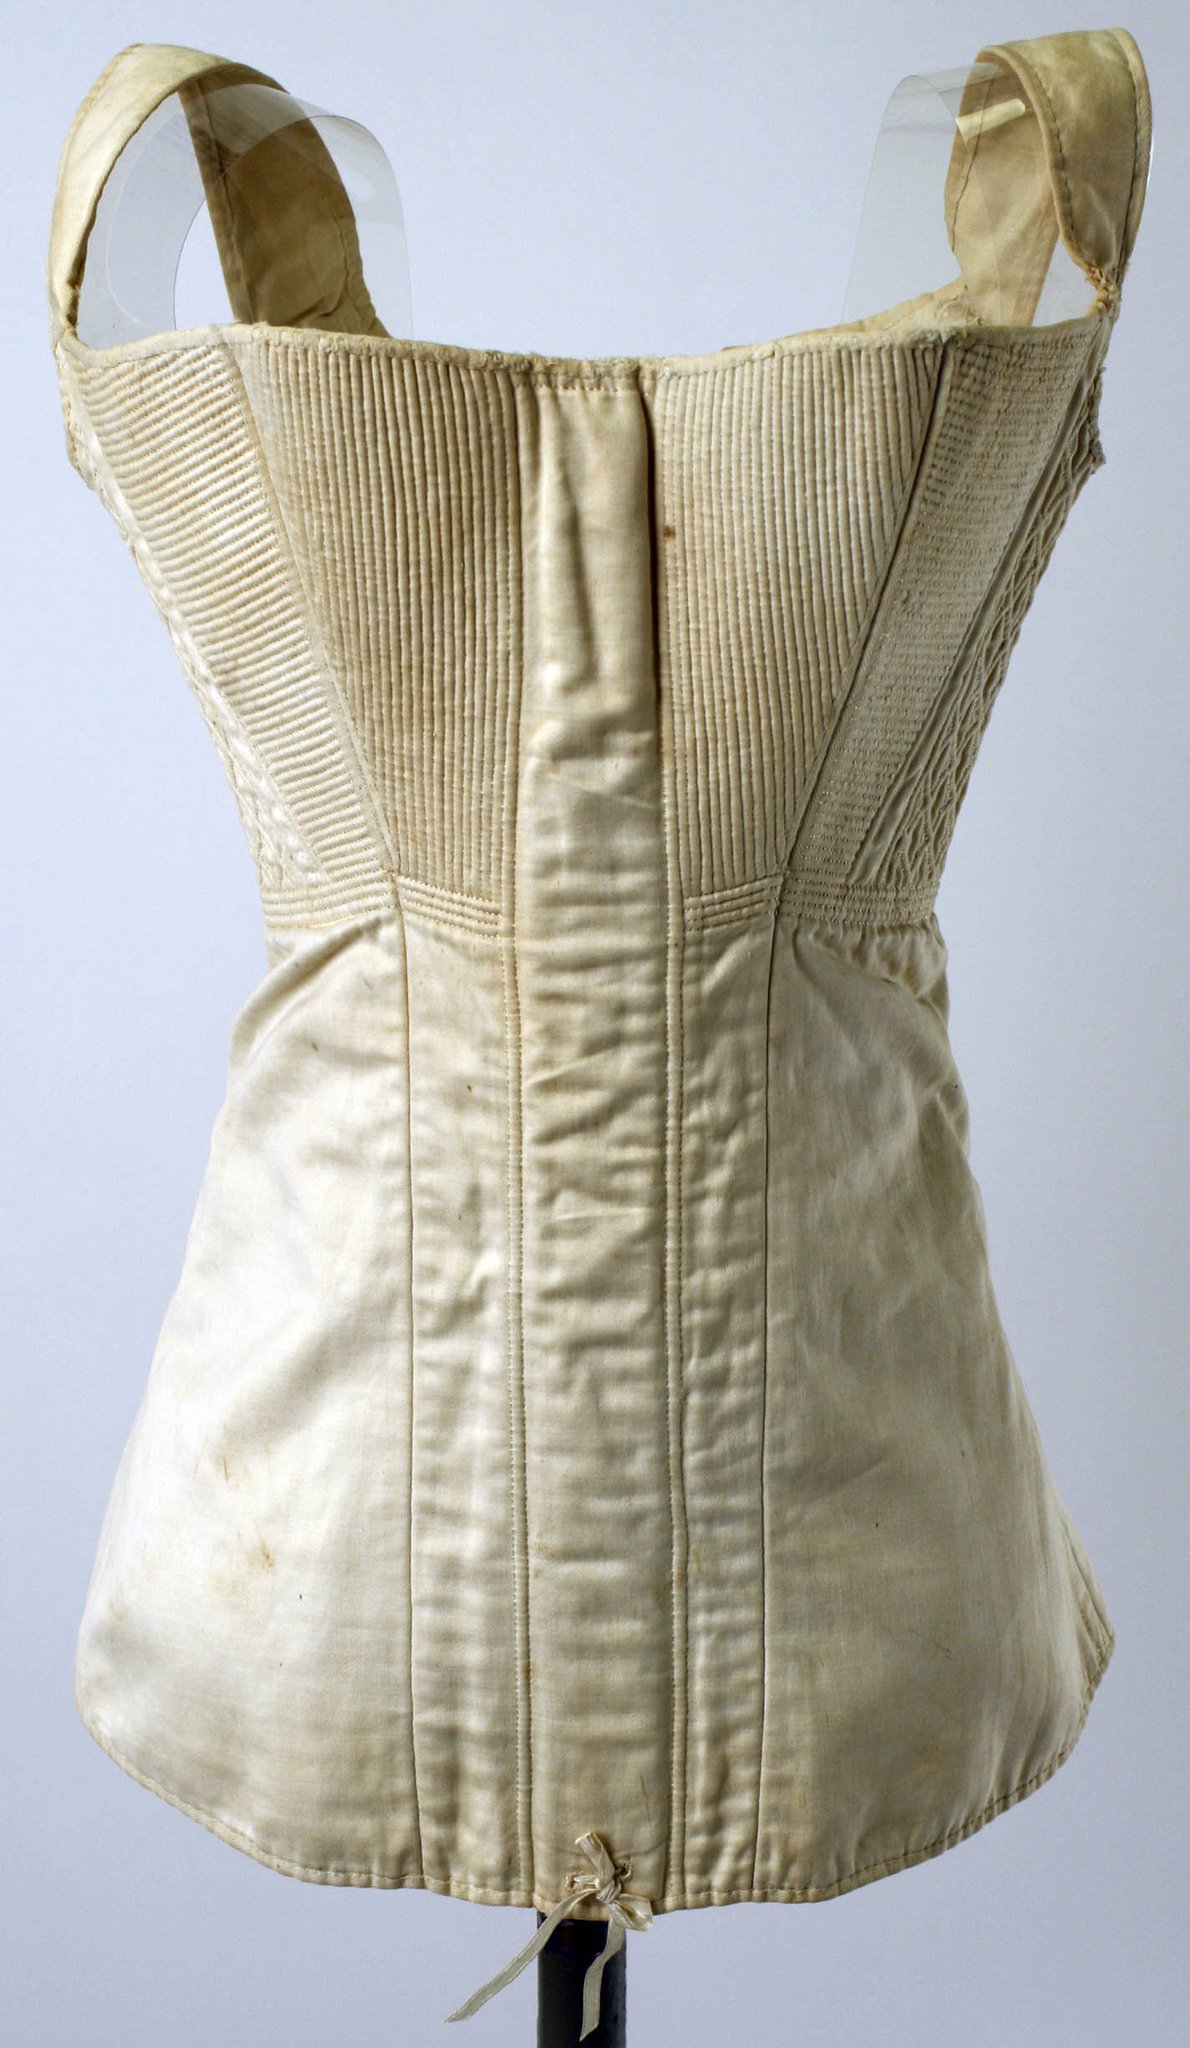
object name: corset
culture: american or european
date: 1820-1829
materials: cotton